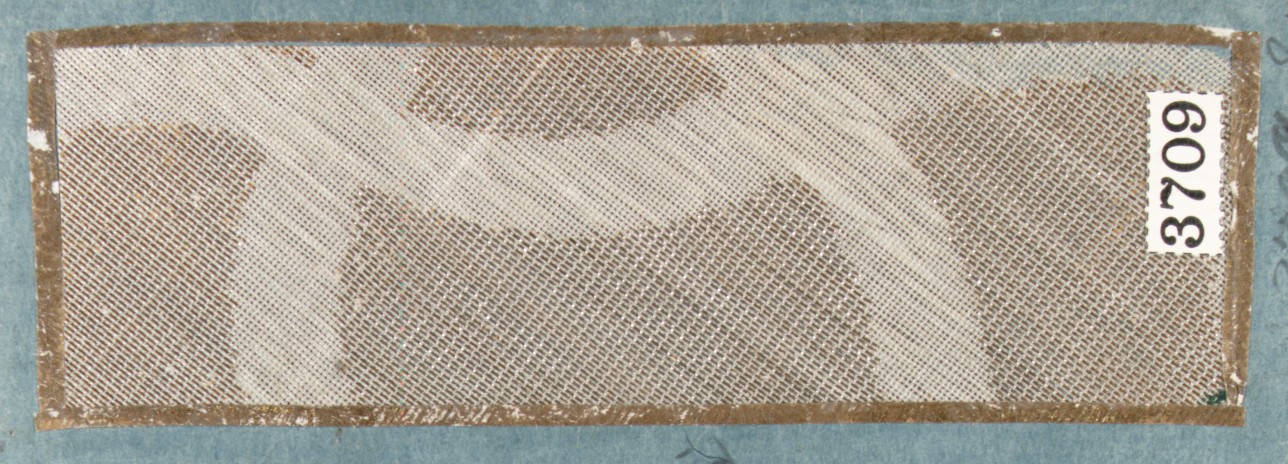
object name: sample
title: Textile Sample from Sample Book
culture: japanese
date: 1801-1900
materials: silk